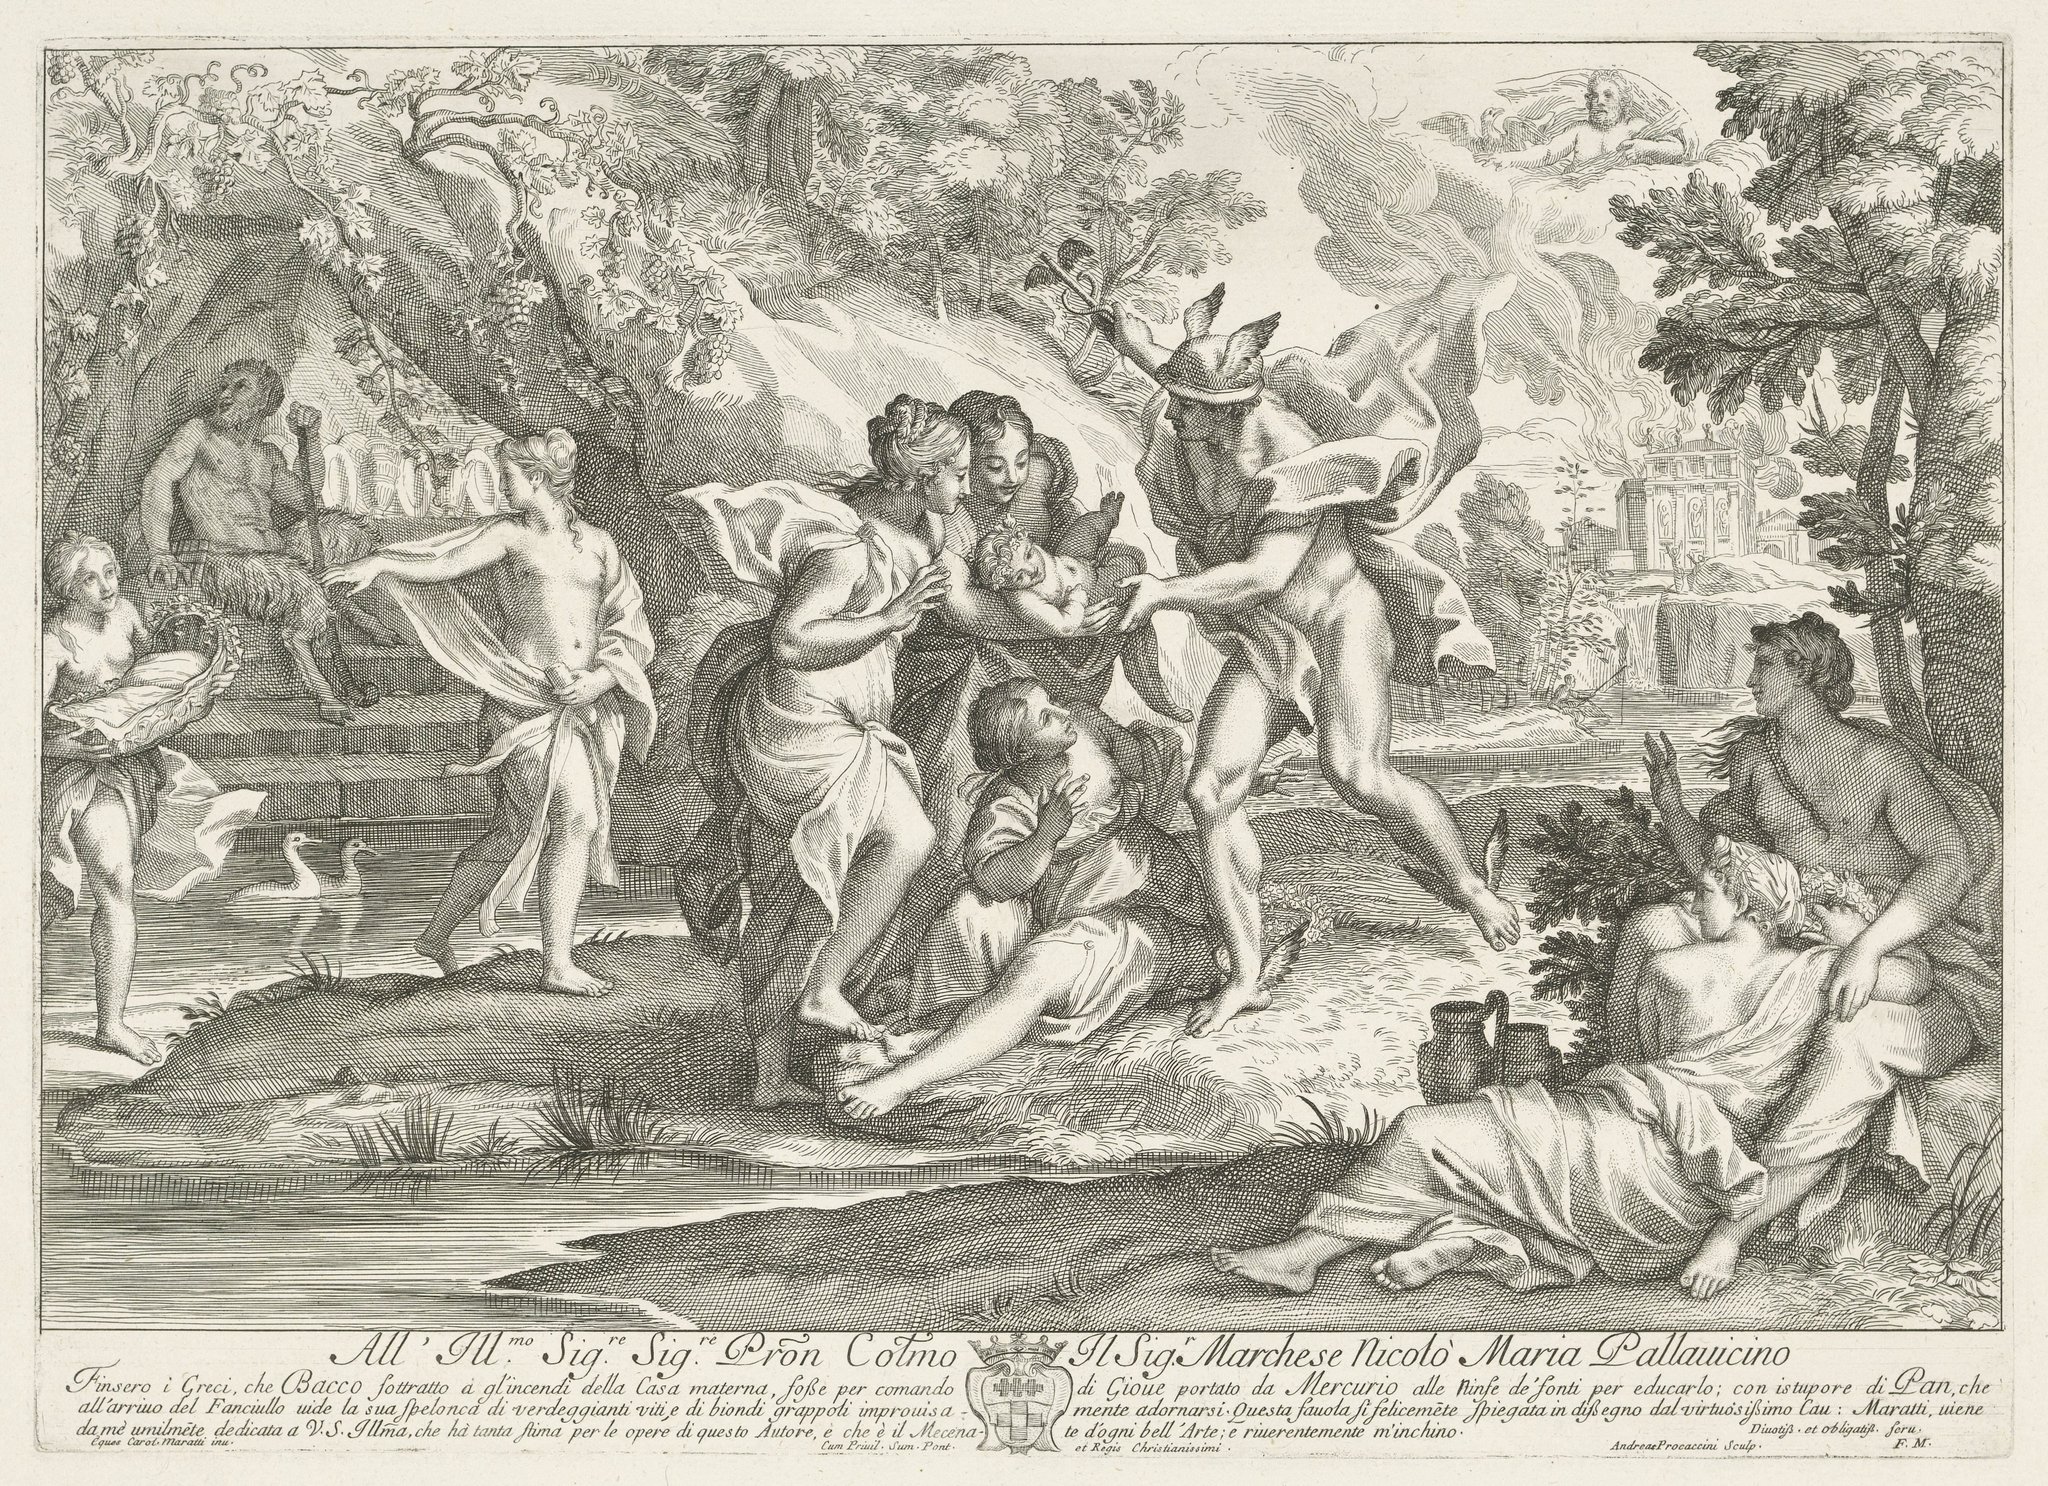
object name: print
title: Mercurius geeft Bacchus aan de nimfen van Nysa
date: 1681-1734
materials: paper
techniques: etching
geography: vatican city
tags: (story of) mercury (hermes), mercury hands the baby bacchus over to the nymphs of nysa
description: Mercurius geeft het kind Bacchus ter opvoeding aan de nimfen van Nysa. Italiaanse tekst en wapenschild in ondermarge.